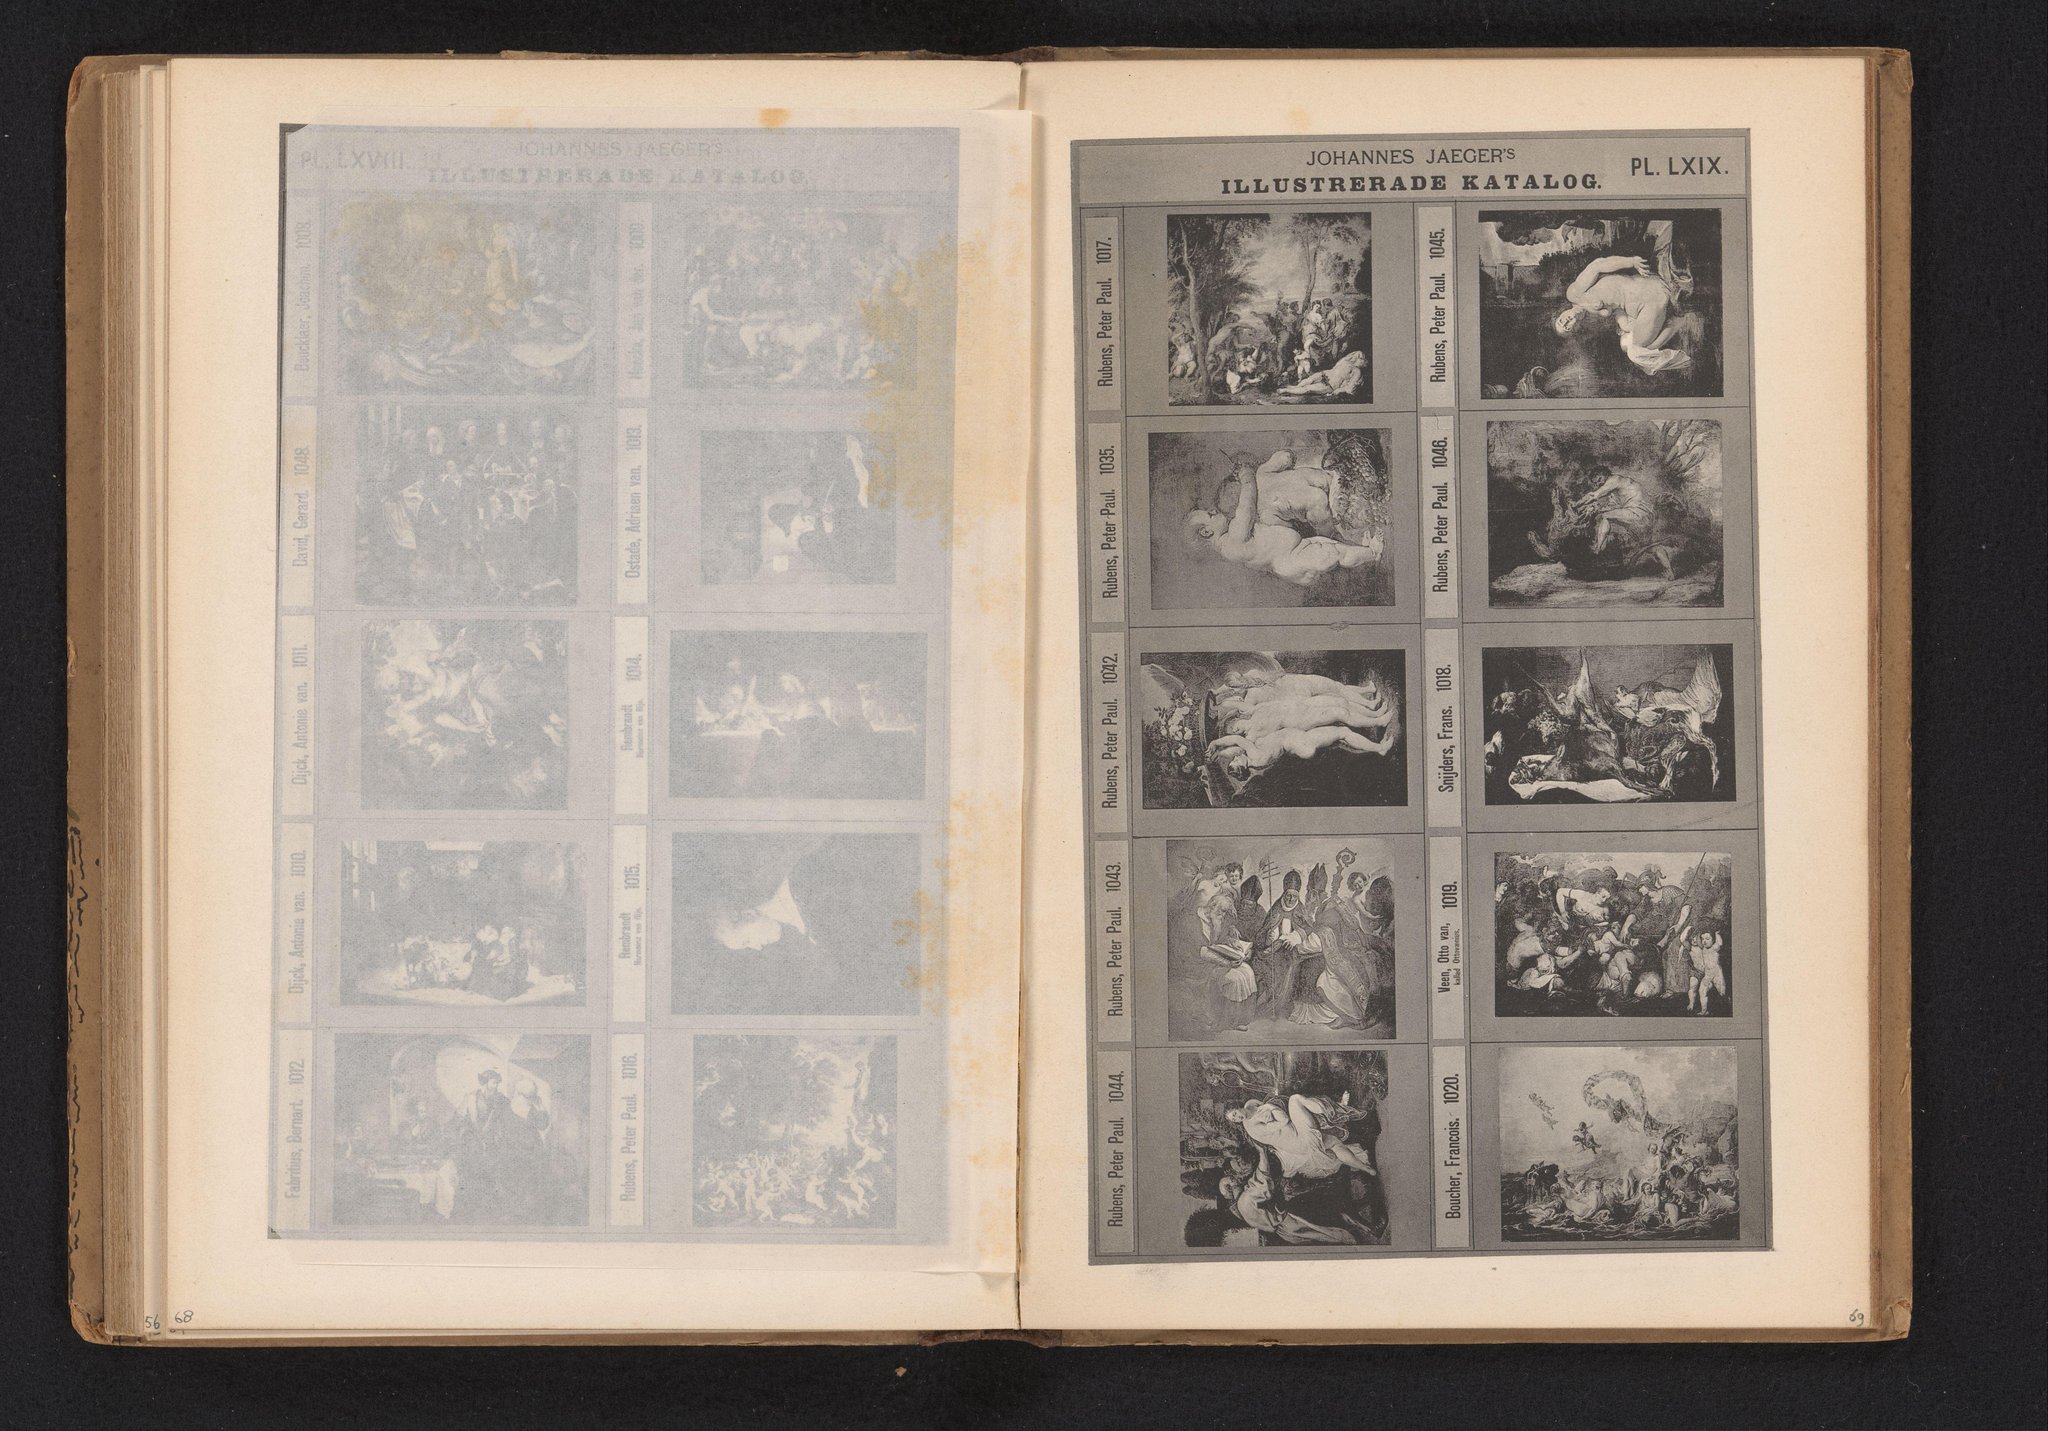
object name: reproduction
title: Fotoreproductie van tien schilderijen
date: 1872-1882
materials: paper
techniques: photograph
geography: stockholm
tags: picture, painting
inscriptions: number: ‘PL. LXIX.’